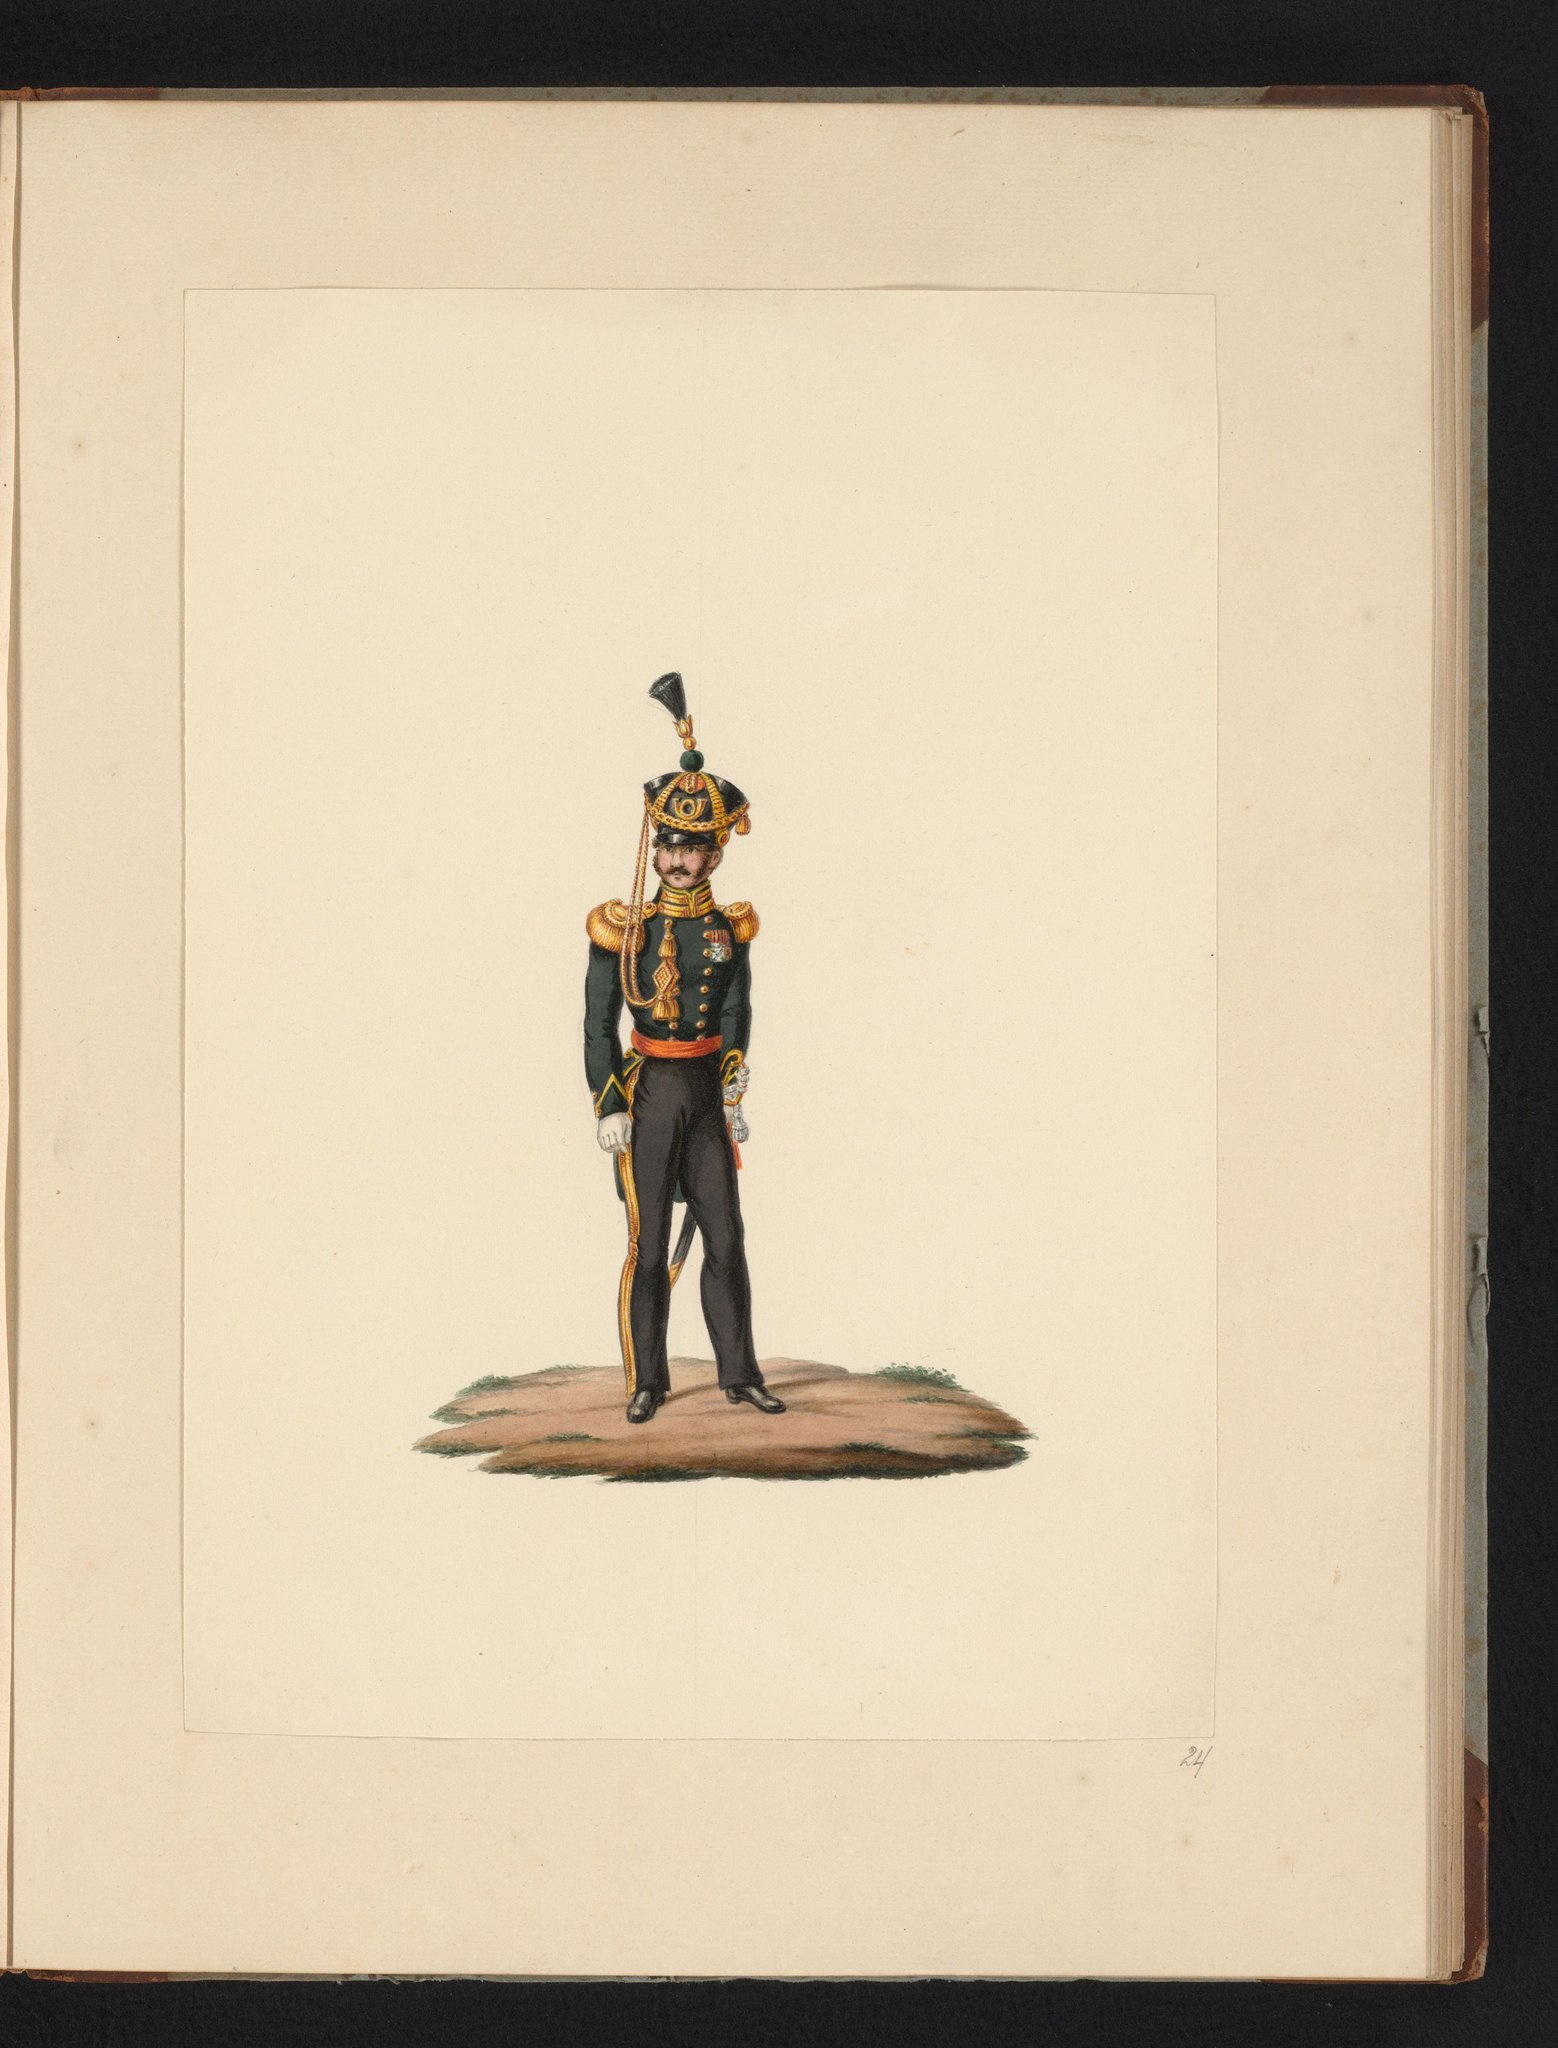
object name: drawing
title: Kapitein van de jagers, 1830-1831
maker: Anonymous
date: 1831-1832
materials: paper, pencil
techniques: brush, lacquer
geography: netherlands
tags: professional clothes, (military) uniforms, netherlands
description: Een kapitein van de jagers, te voet. Onderdeel van het album met 39 ingeplakte tekeningen van militairen van de Koninklijke Nederlandsche Armee uit 1830-1831.